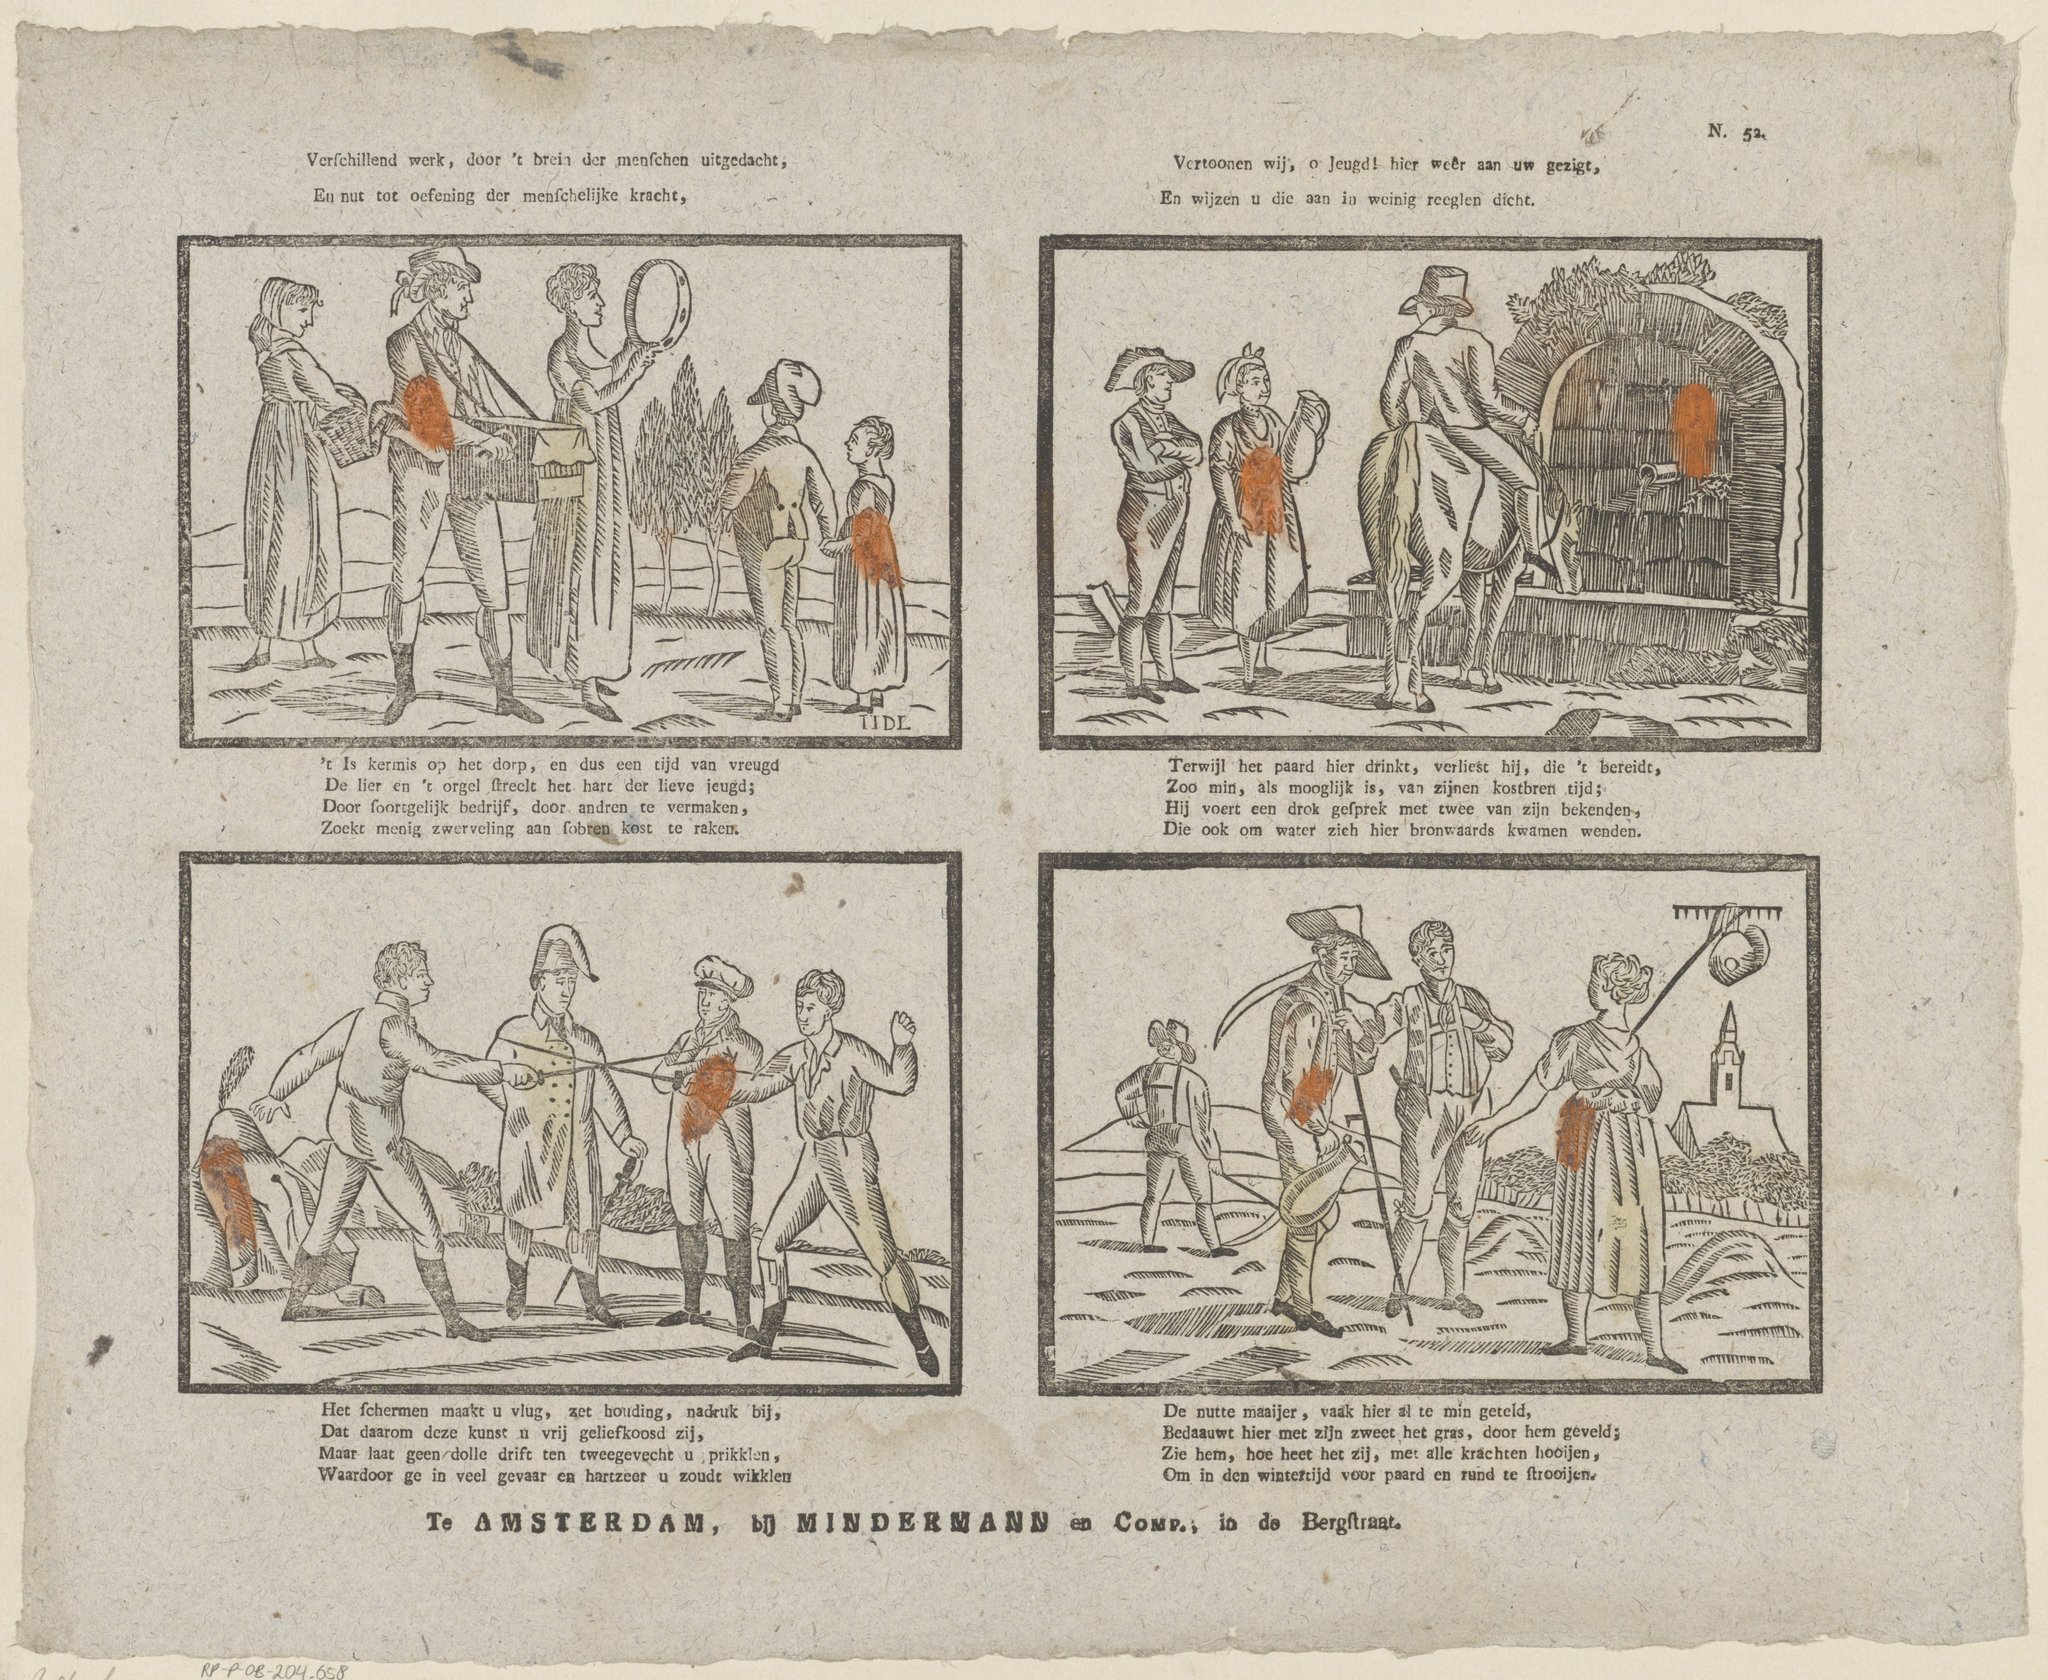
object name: popular print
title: Verschillend werk, door 't brein des menschen uitgedacht, / En nut tot oefening der menschelijke kracht, / Vertoonen wij, o jeugd! hier weêr aan uw gezigt, / En wijzen u die aan in weinig reeglen dicht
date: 1822-1849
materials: paper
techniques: colour, letterpress printing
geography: netherlands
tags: riding a horse, ass, or mule; rider, horseman, farmers, agriculture, fencing (sport)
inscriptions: collector's mark: Lugt 2760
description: Blad met 4 voorstellingen van verschillende bezigheden, waaronder schermen en op het land werken. Onder elke voorstelling een vierregelig vers. Genummerd rechtsboven: N. 52.